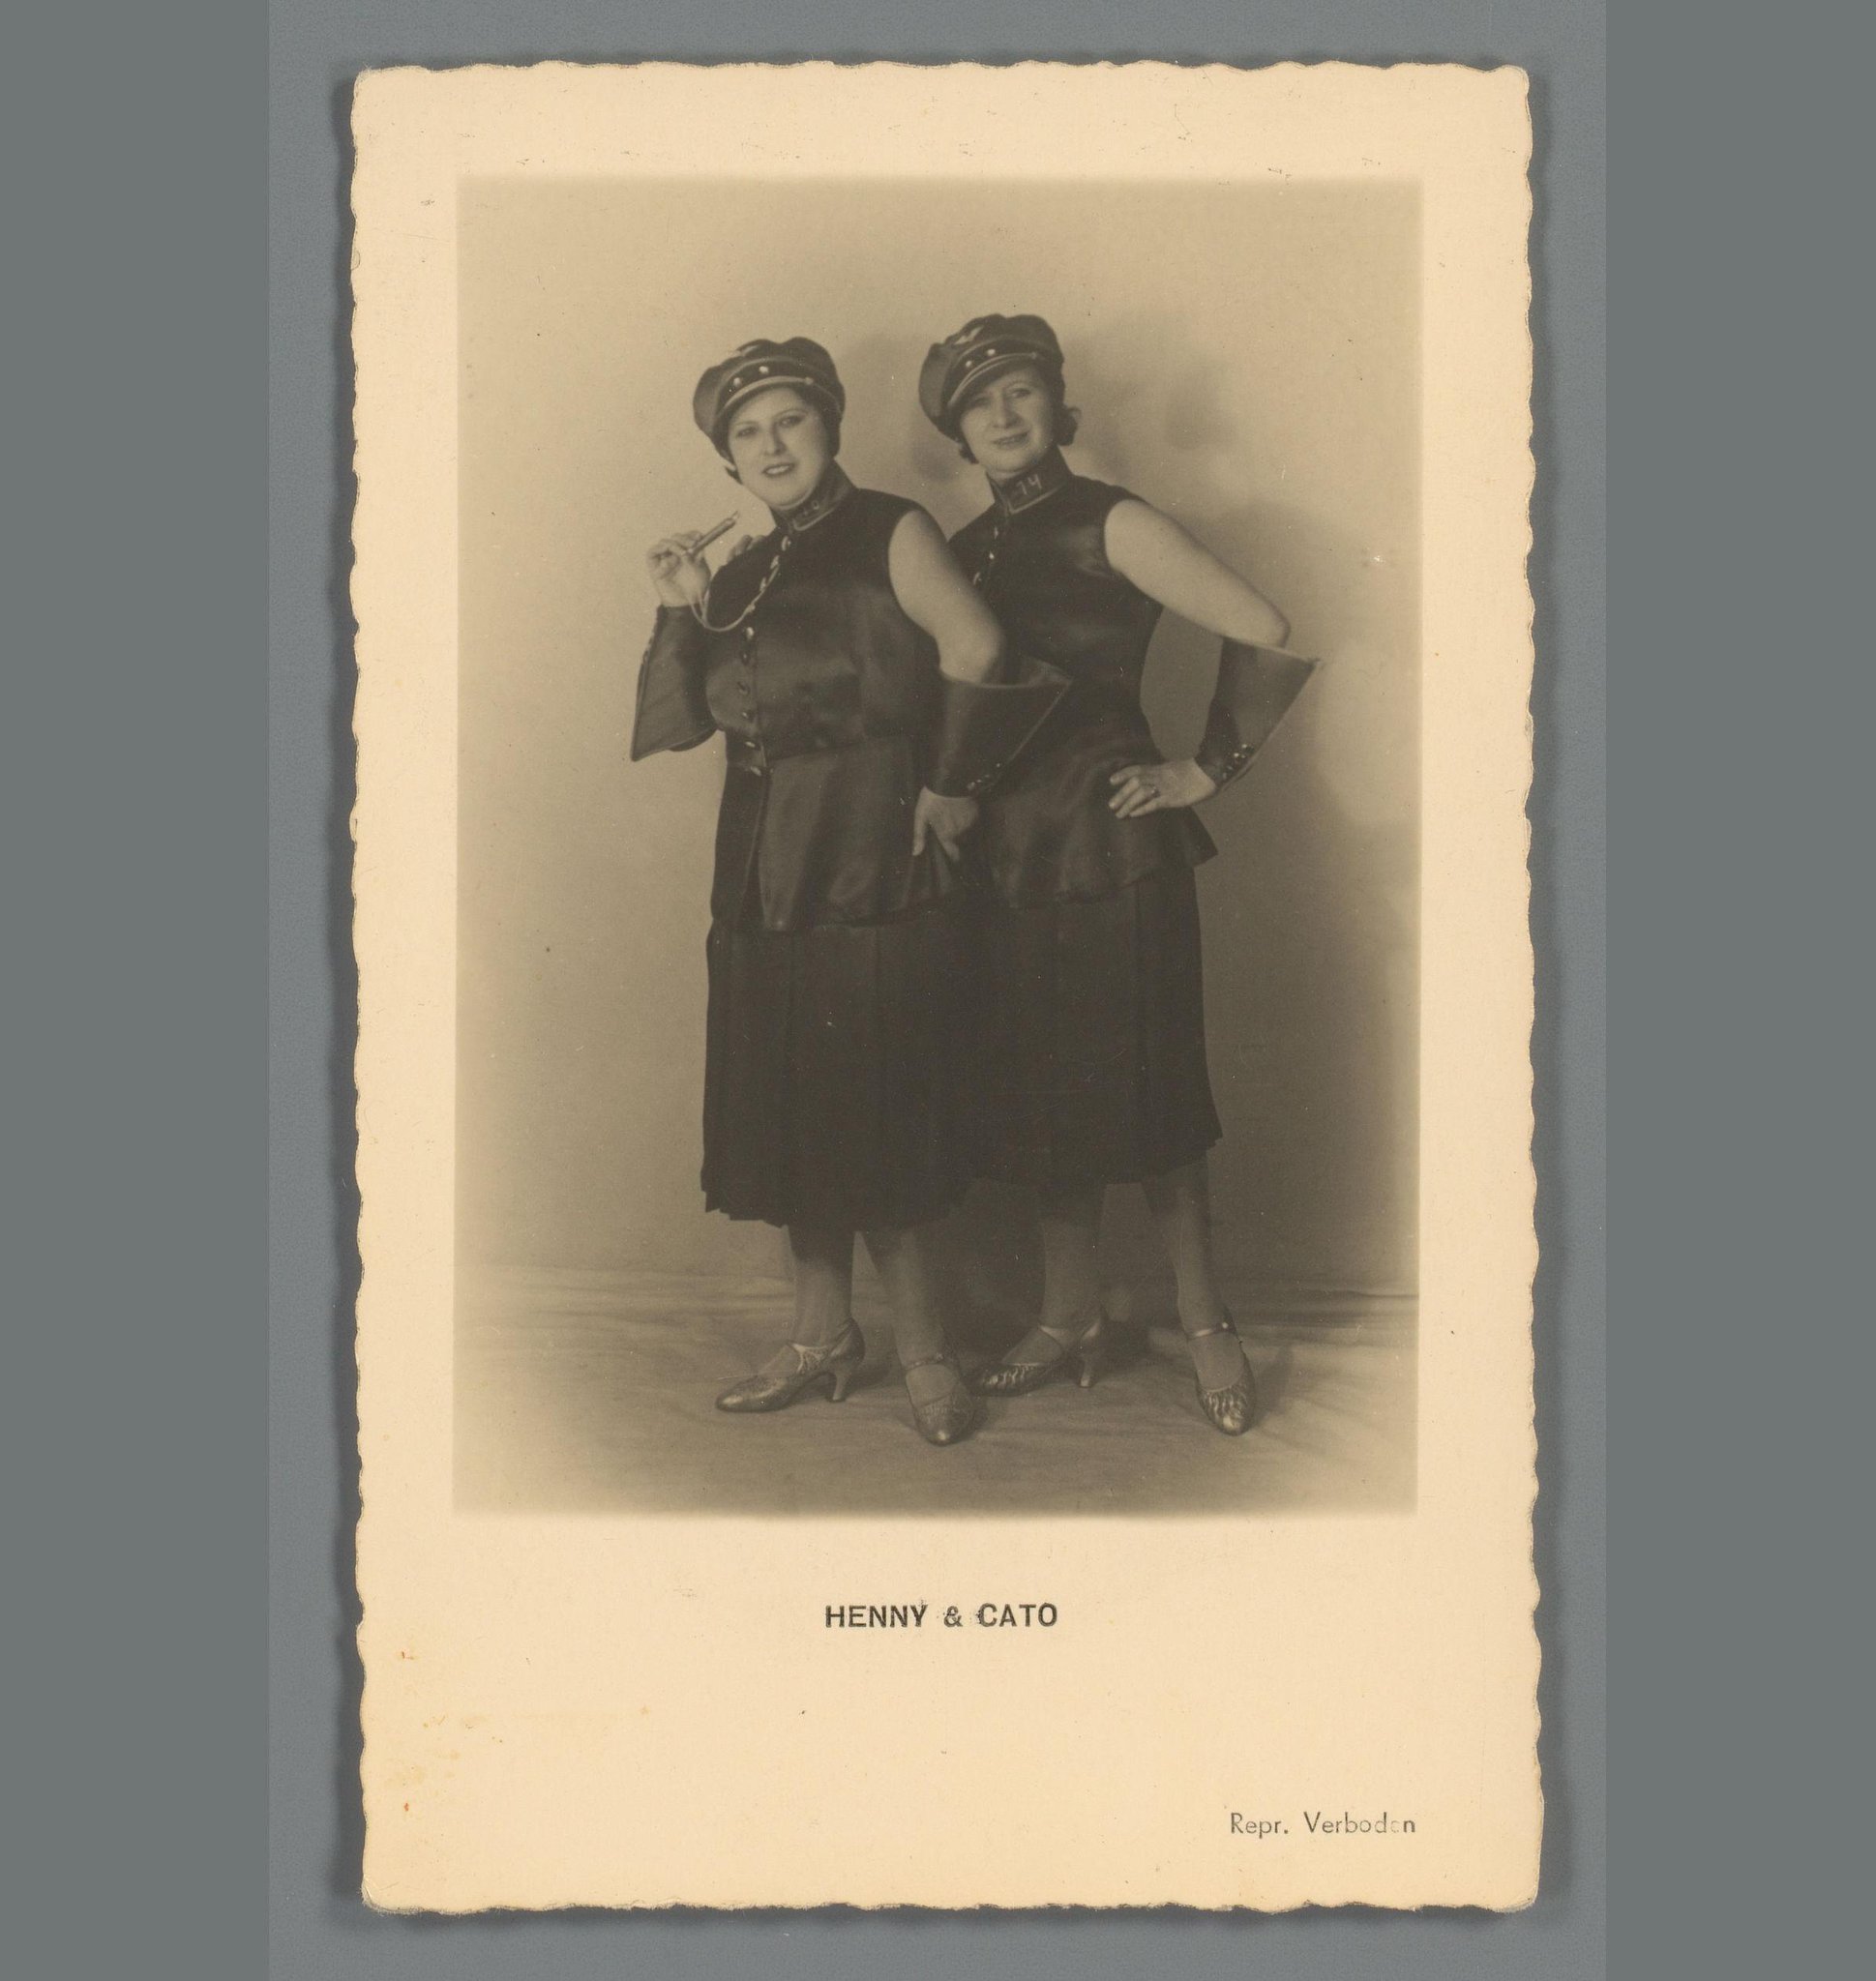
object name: photograph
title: Portret van Henny en Cato Merks in uniform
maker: Anonymous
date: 1920-1950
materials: paper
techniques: gelatin silver print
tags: historical persons - bb - woman, portrait of cabaret-artiste